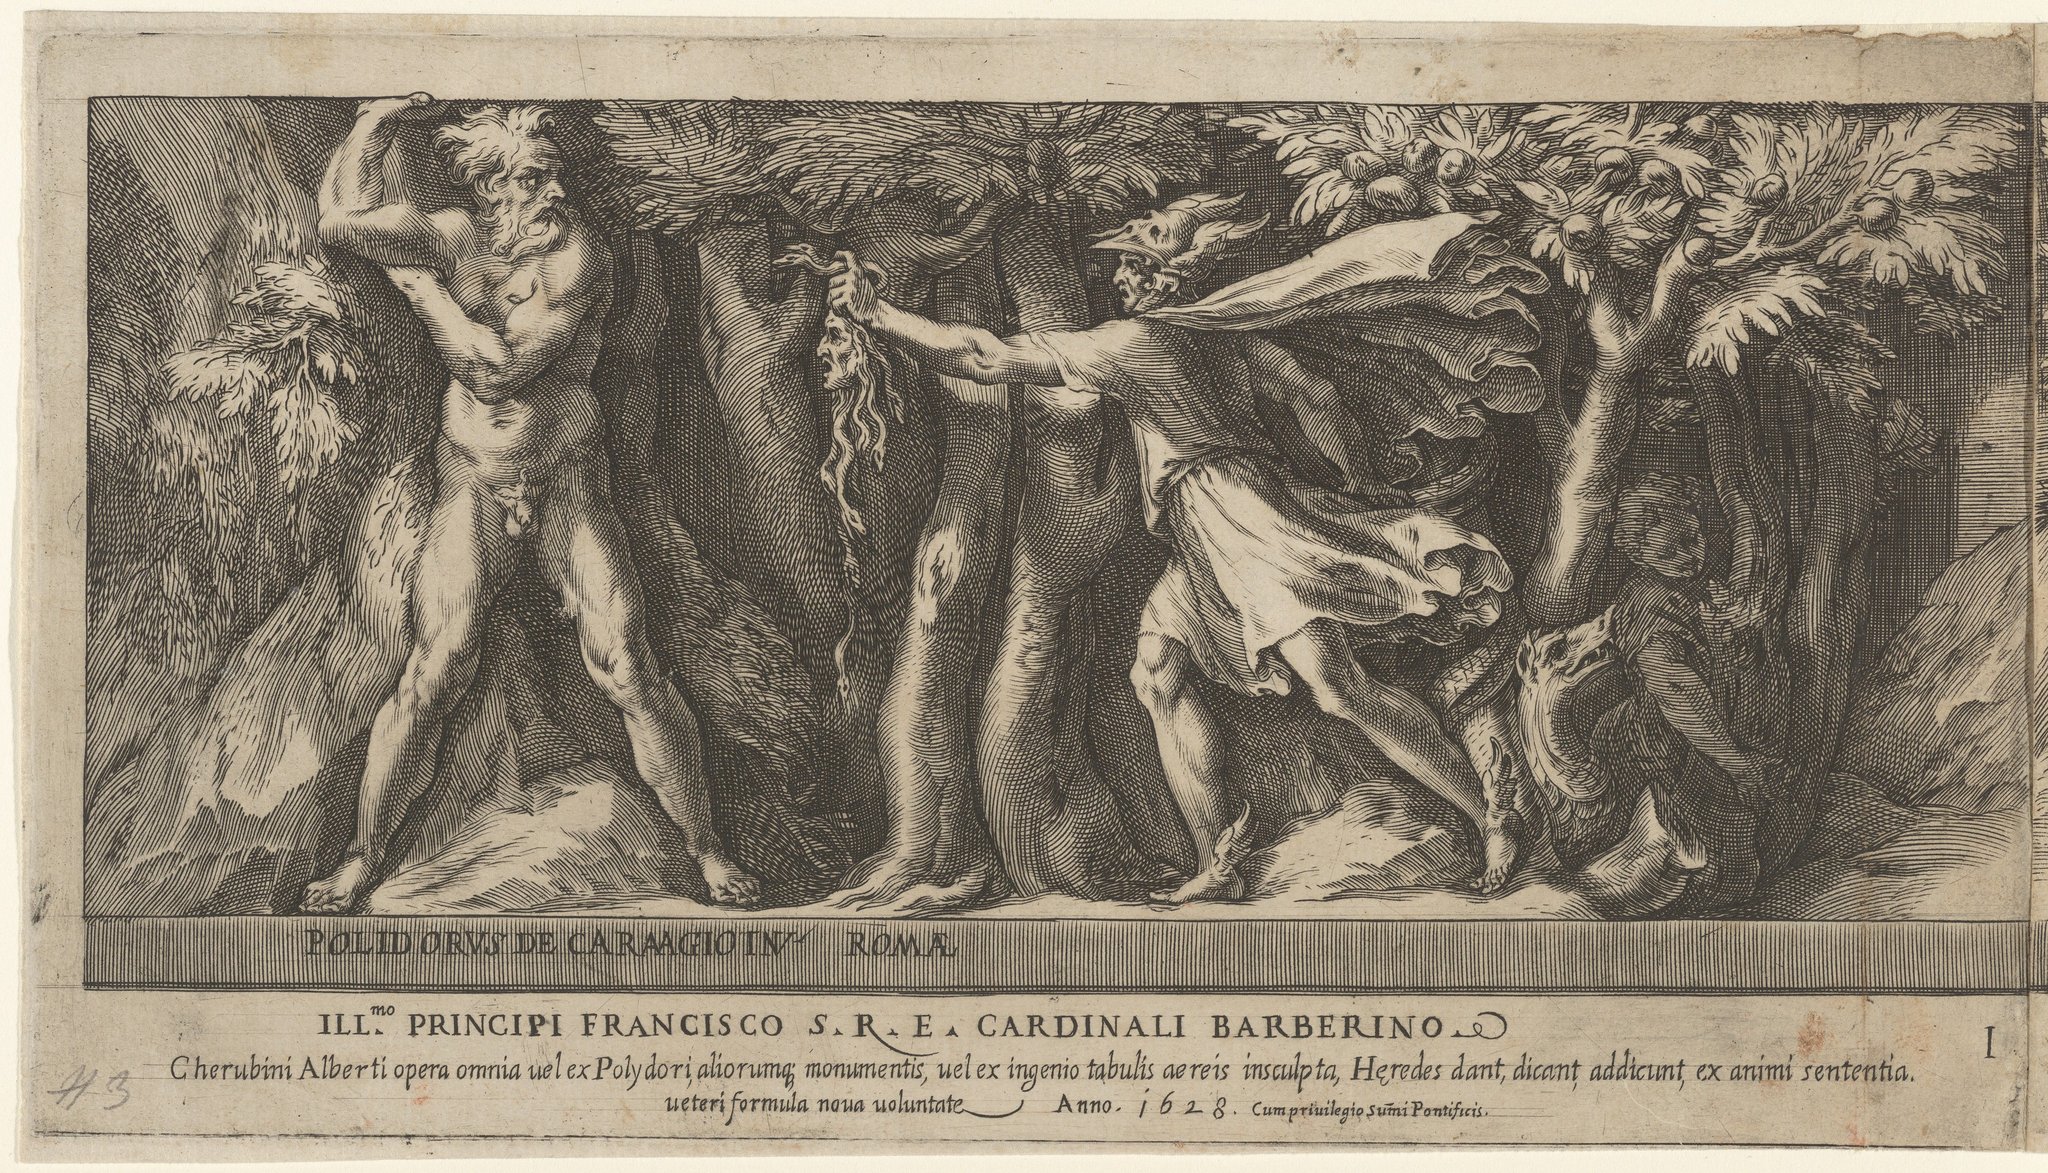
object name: print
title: Perseus changing Atlas into a mountan with the head of Medusa, from Perseus and the Golden Apples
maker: cherubino alberti (zaccaria mattia)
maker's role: artist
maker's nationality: italian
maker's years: 1553-1615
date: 1570-1615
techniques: engraving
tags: medusa,perseus,trees